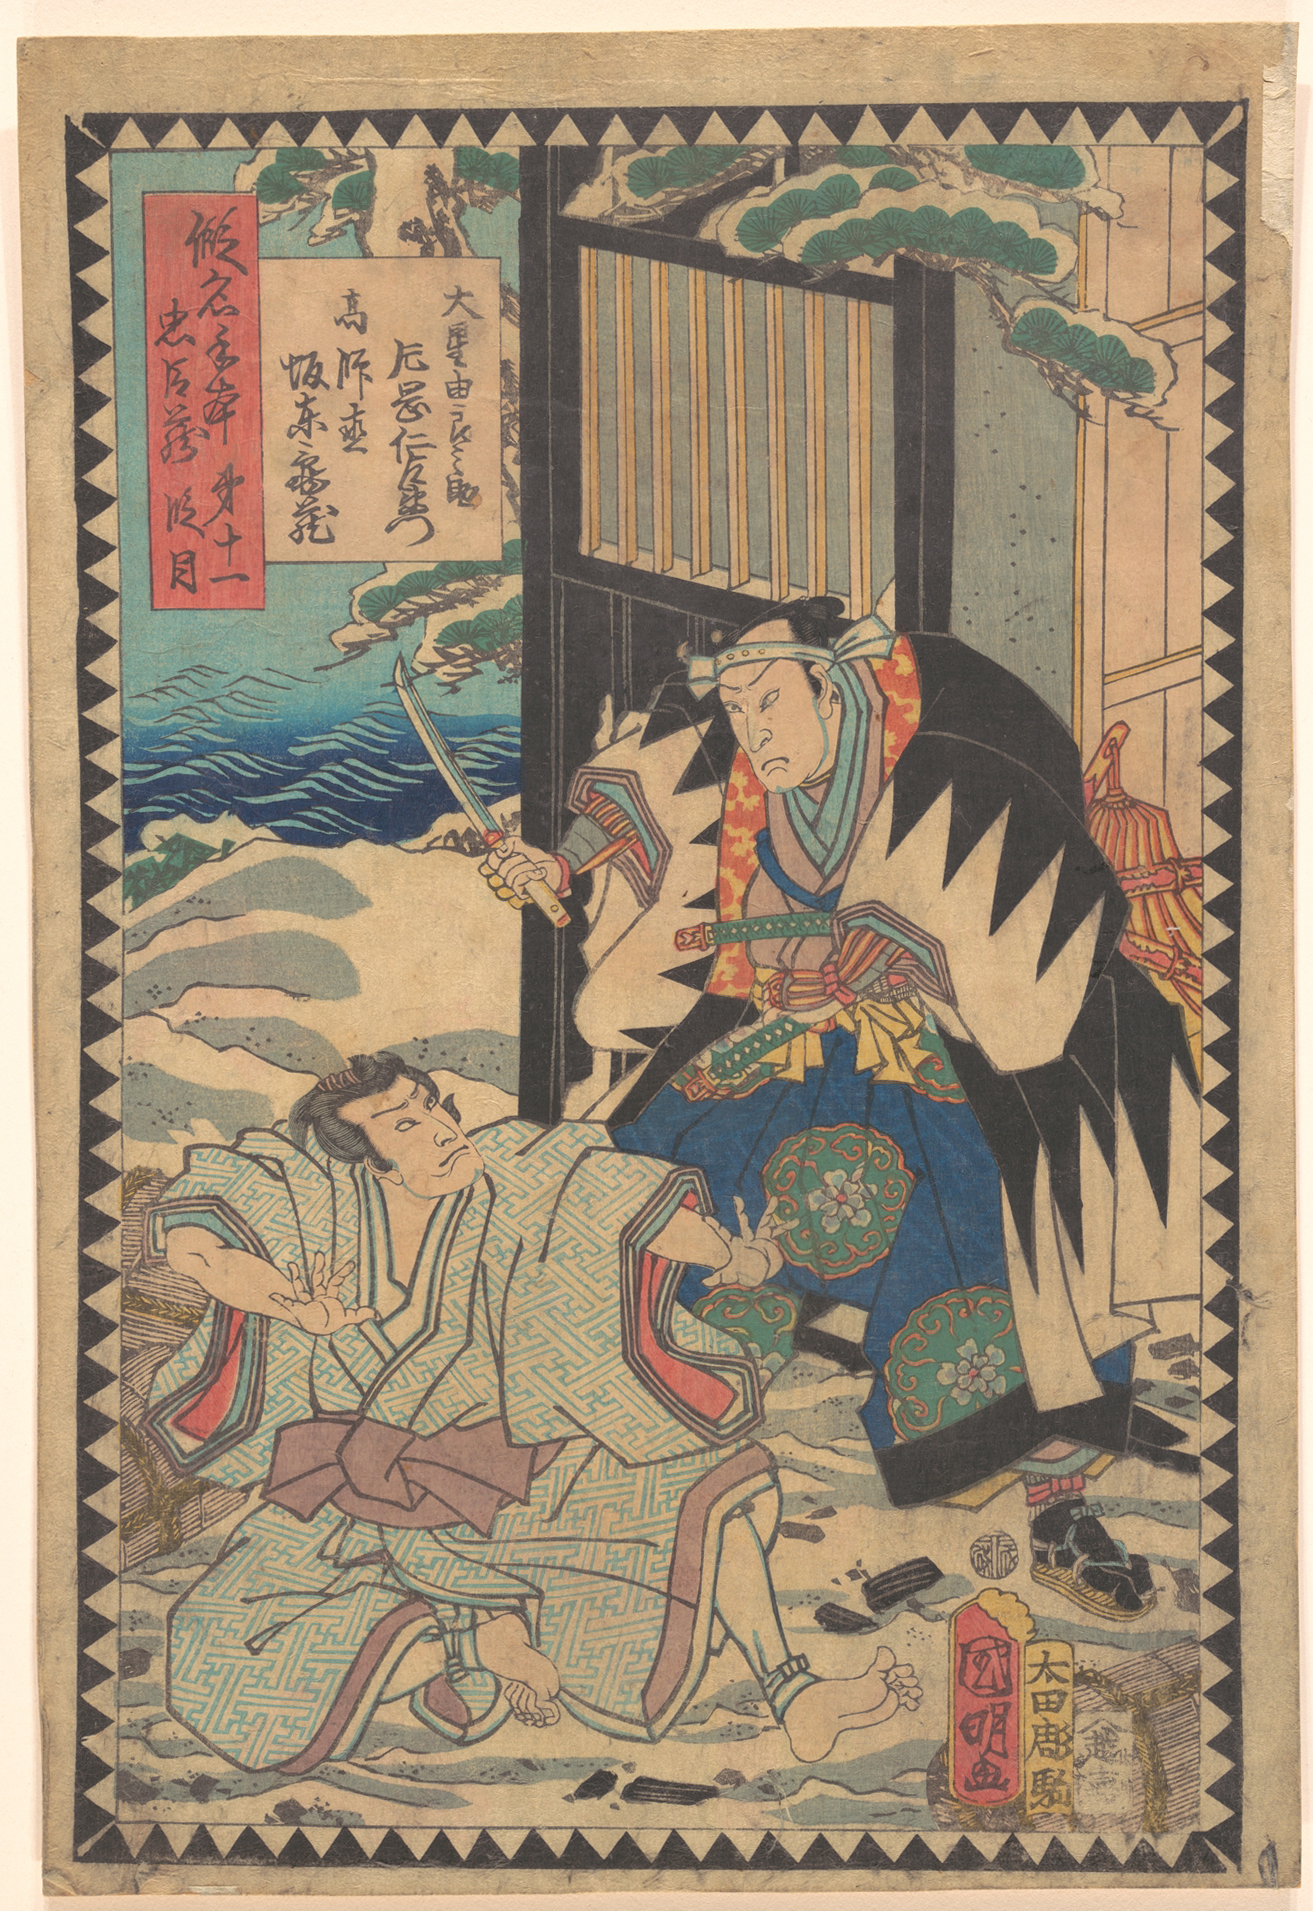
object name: print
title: Act XI (Dai jūichidanme): Actors Kataoka Nizaemon VIII as Ōboshi Yuranosuke and Bandō Kamezō I as Kō no Moronao, from the series The Storehouse of Loyal Retainers, a Primer (Kanadehon chūshingura)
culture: japanese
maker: utagawa kuniaki ii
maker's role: artist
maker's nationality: japanese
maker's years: 1835-1888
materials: ink, paper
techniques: woodblock print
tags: men,actors